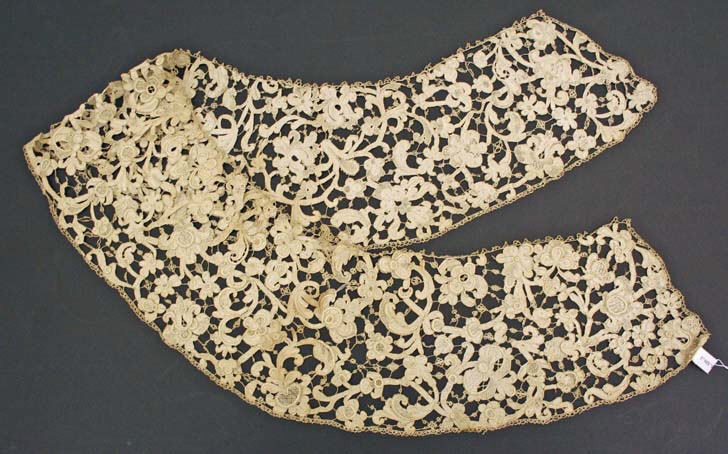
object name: collar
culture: italian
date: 1601-1700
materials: linen